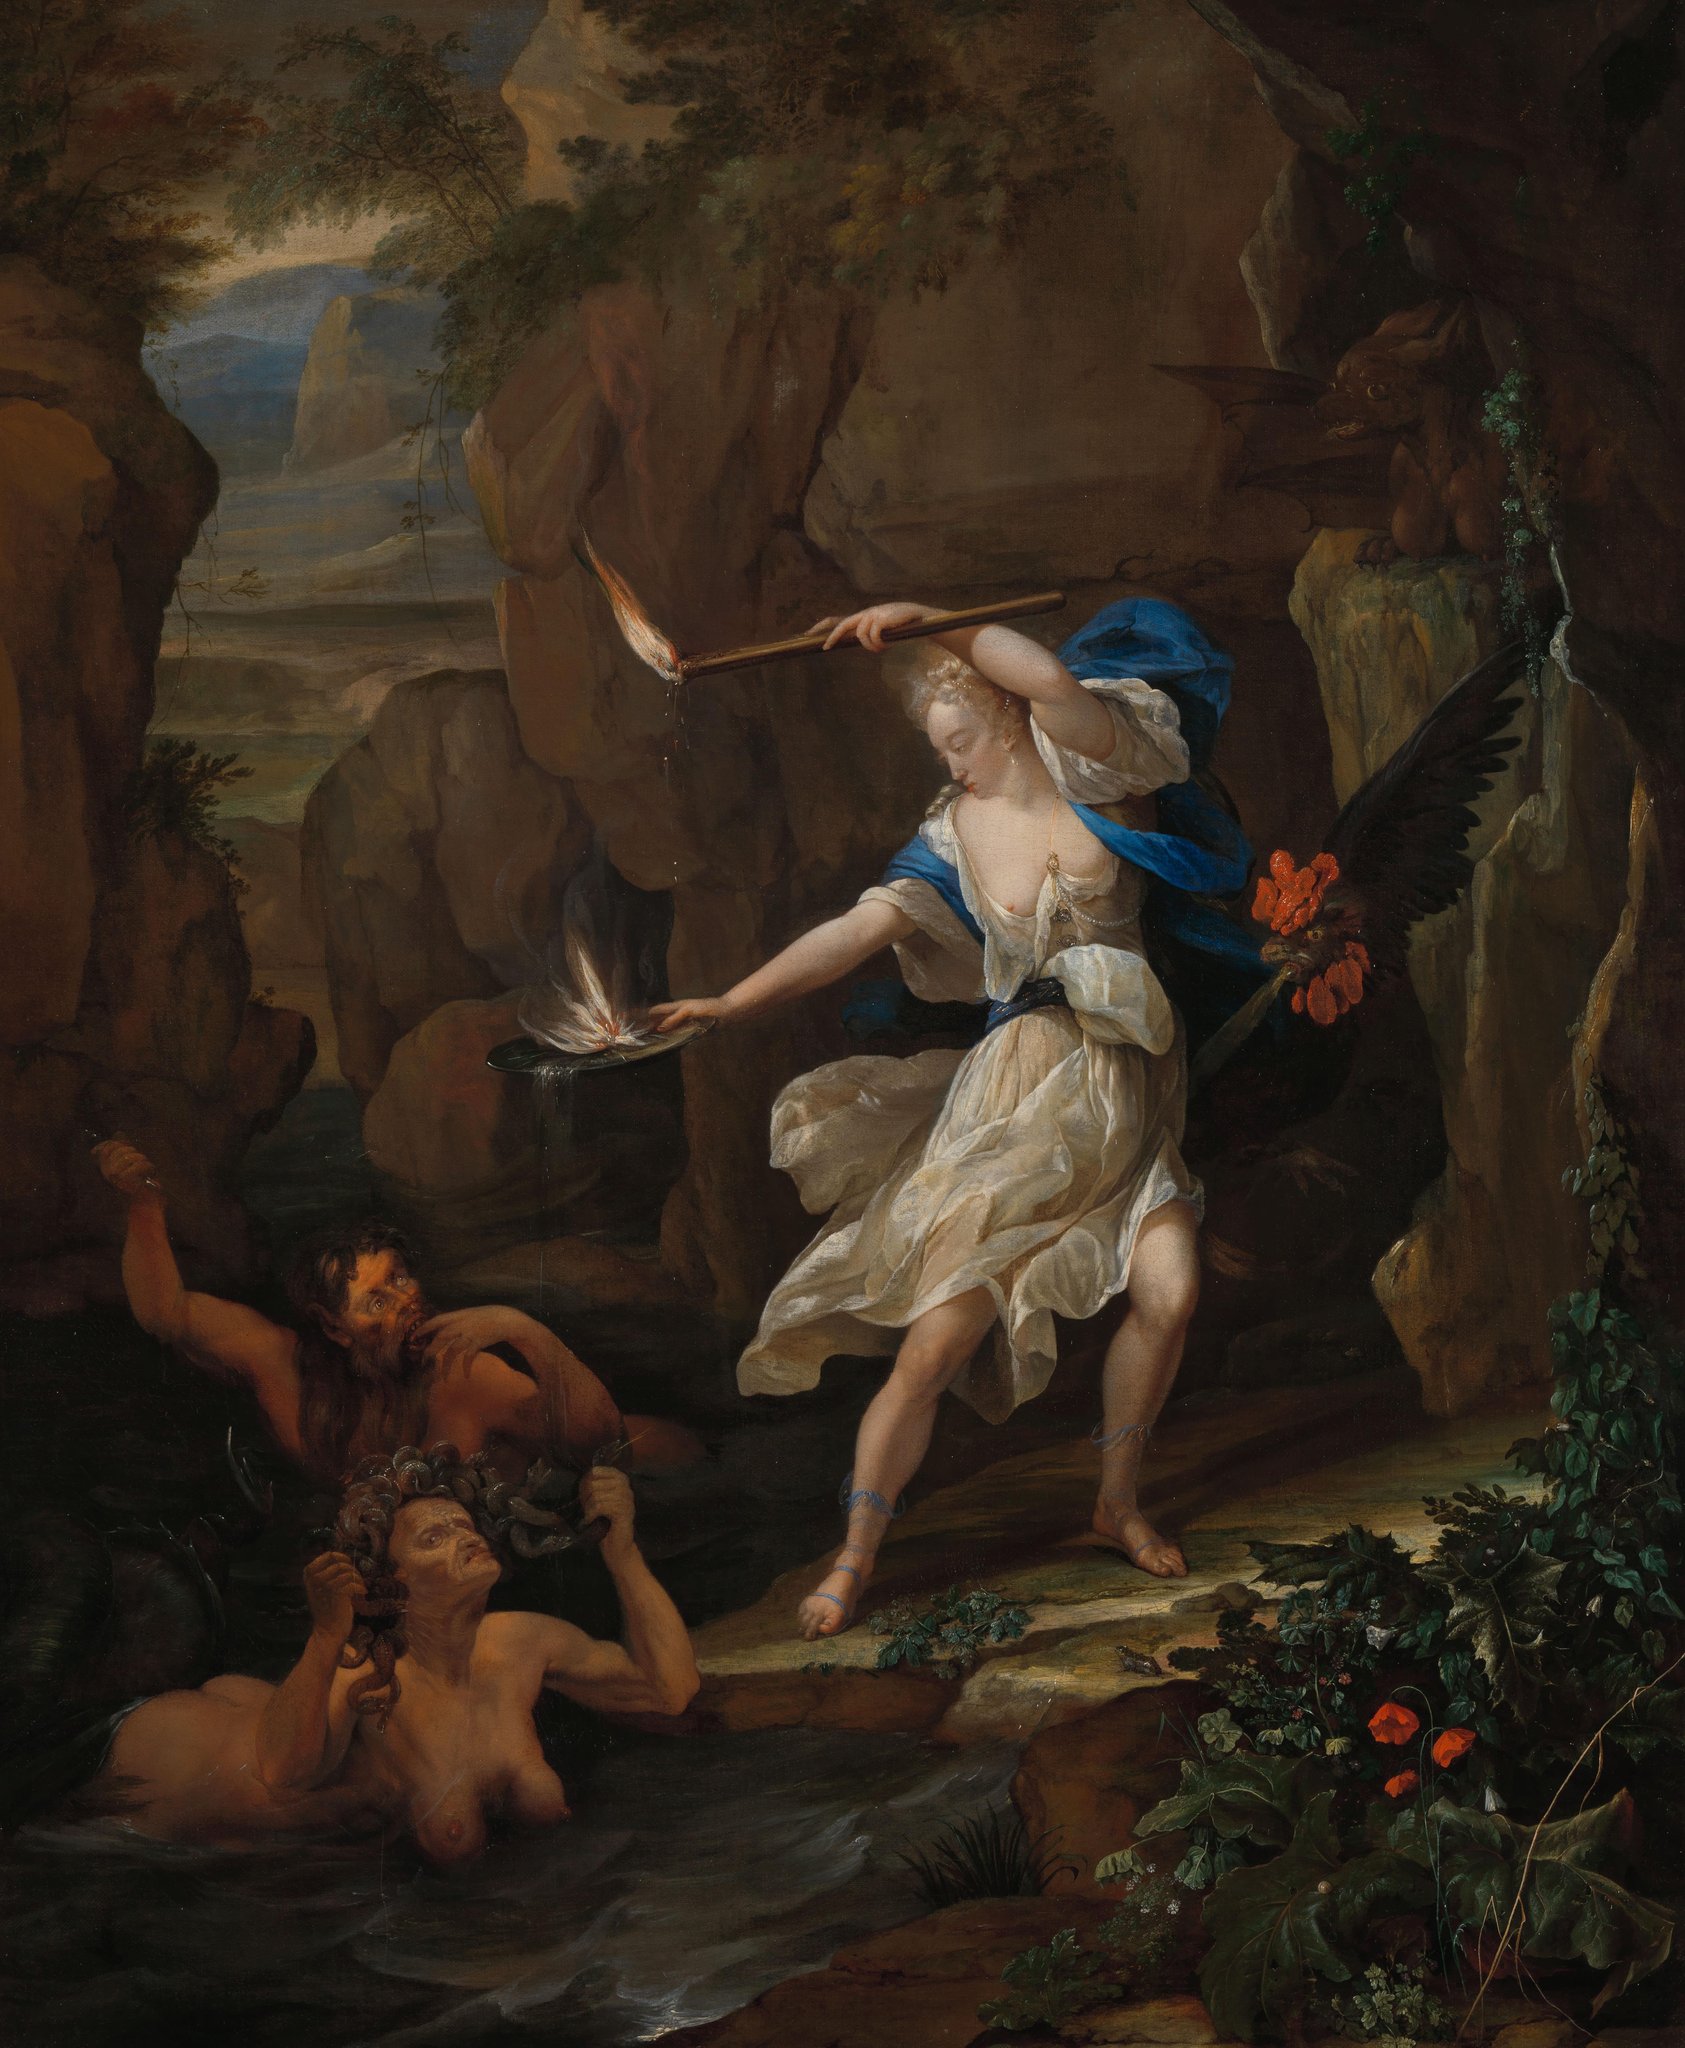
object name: painting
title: Circe Punishes Glaucus by Turning Scylla into a Monster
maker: eglon van der neer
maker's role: painter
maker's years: 1634-1703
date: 1695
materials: canvas, oil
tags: scylla changed into a sea-monster: circe, to whom glaucus has applied for aid in his love suit, changes scylla the sea-nymph into a sea-monster (ovid, metamorphoses xiv 59)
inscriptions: signature and date: ‘... 1695’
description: The unsightly, but good-natured sea god Glaucus was in love with Scylla, but this was unrequited. To win her over, he sought the help of the sorceress Circe. This was a mistake, for Circe was herself in love with him. In a fit of rage, she changed poor Scylla into a monster. Van der Neer set the story from Ovid’s Metamorphoses in sinister surroundings. Gesturing theatrically, the sorceress performs her vengeful deed.